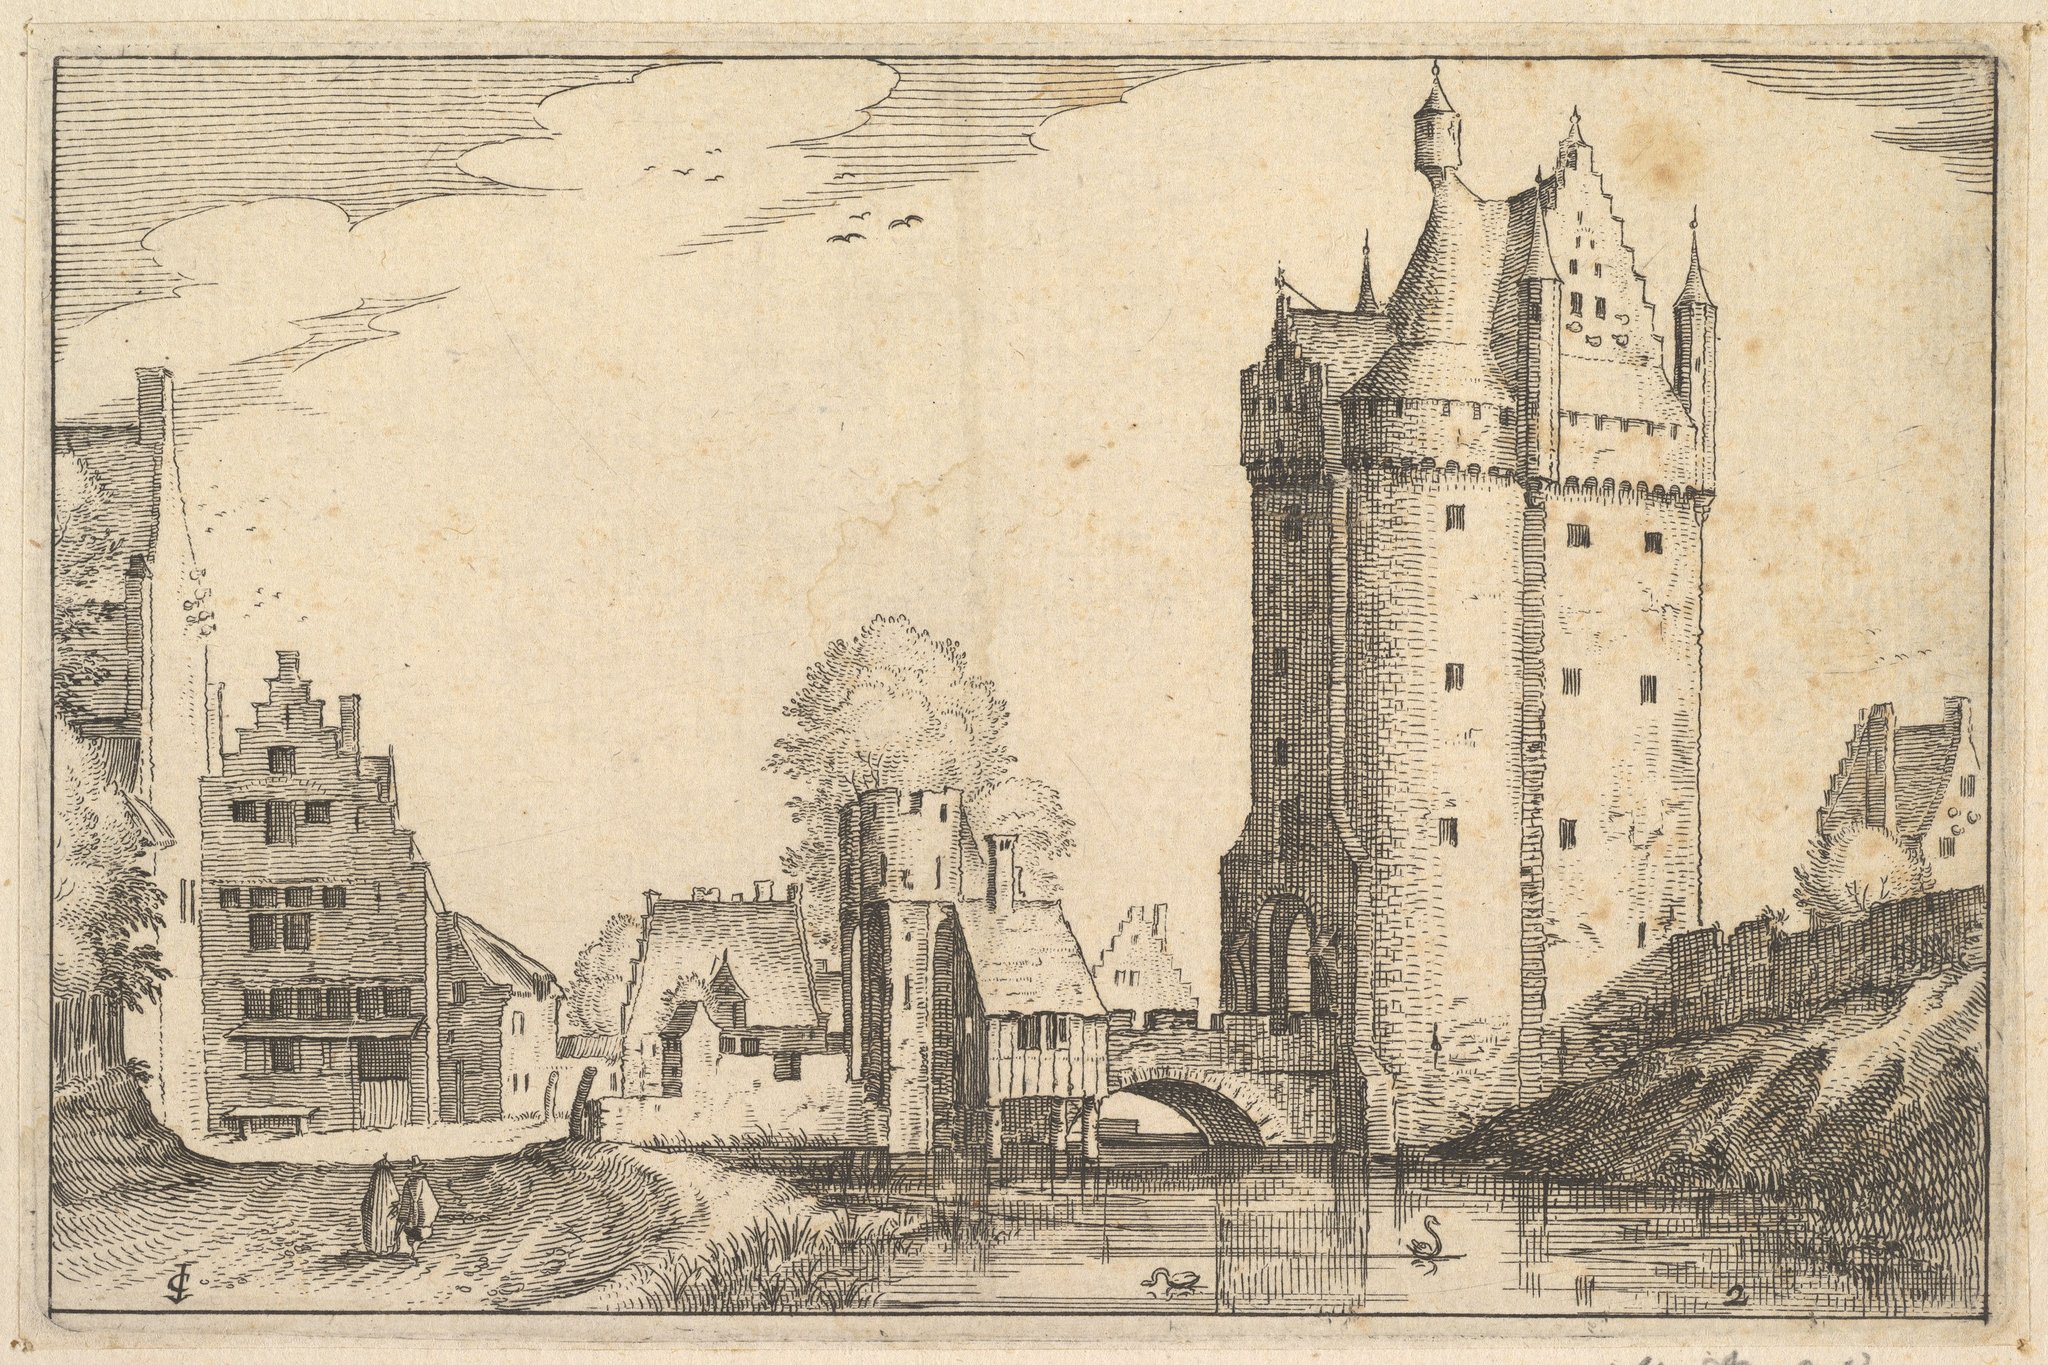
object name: print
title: Town Gate, plate 2 from "Regiunculae et Villae Aliquot Ducatus Brabantiae"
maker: claes jansz. visscher (ii)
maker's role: artist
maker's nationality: dutch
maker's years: 1586-1652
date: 1610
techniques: etching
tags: castles,gates,roads,villages,swans